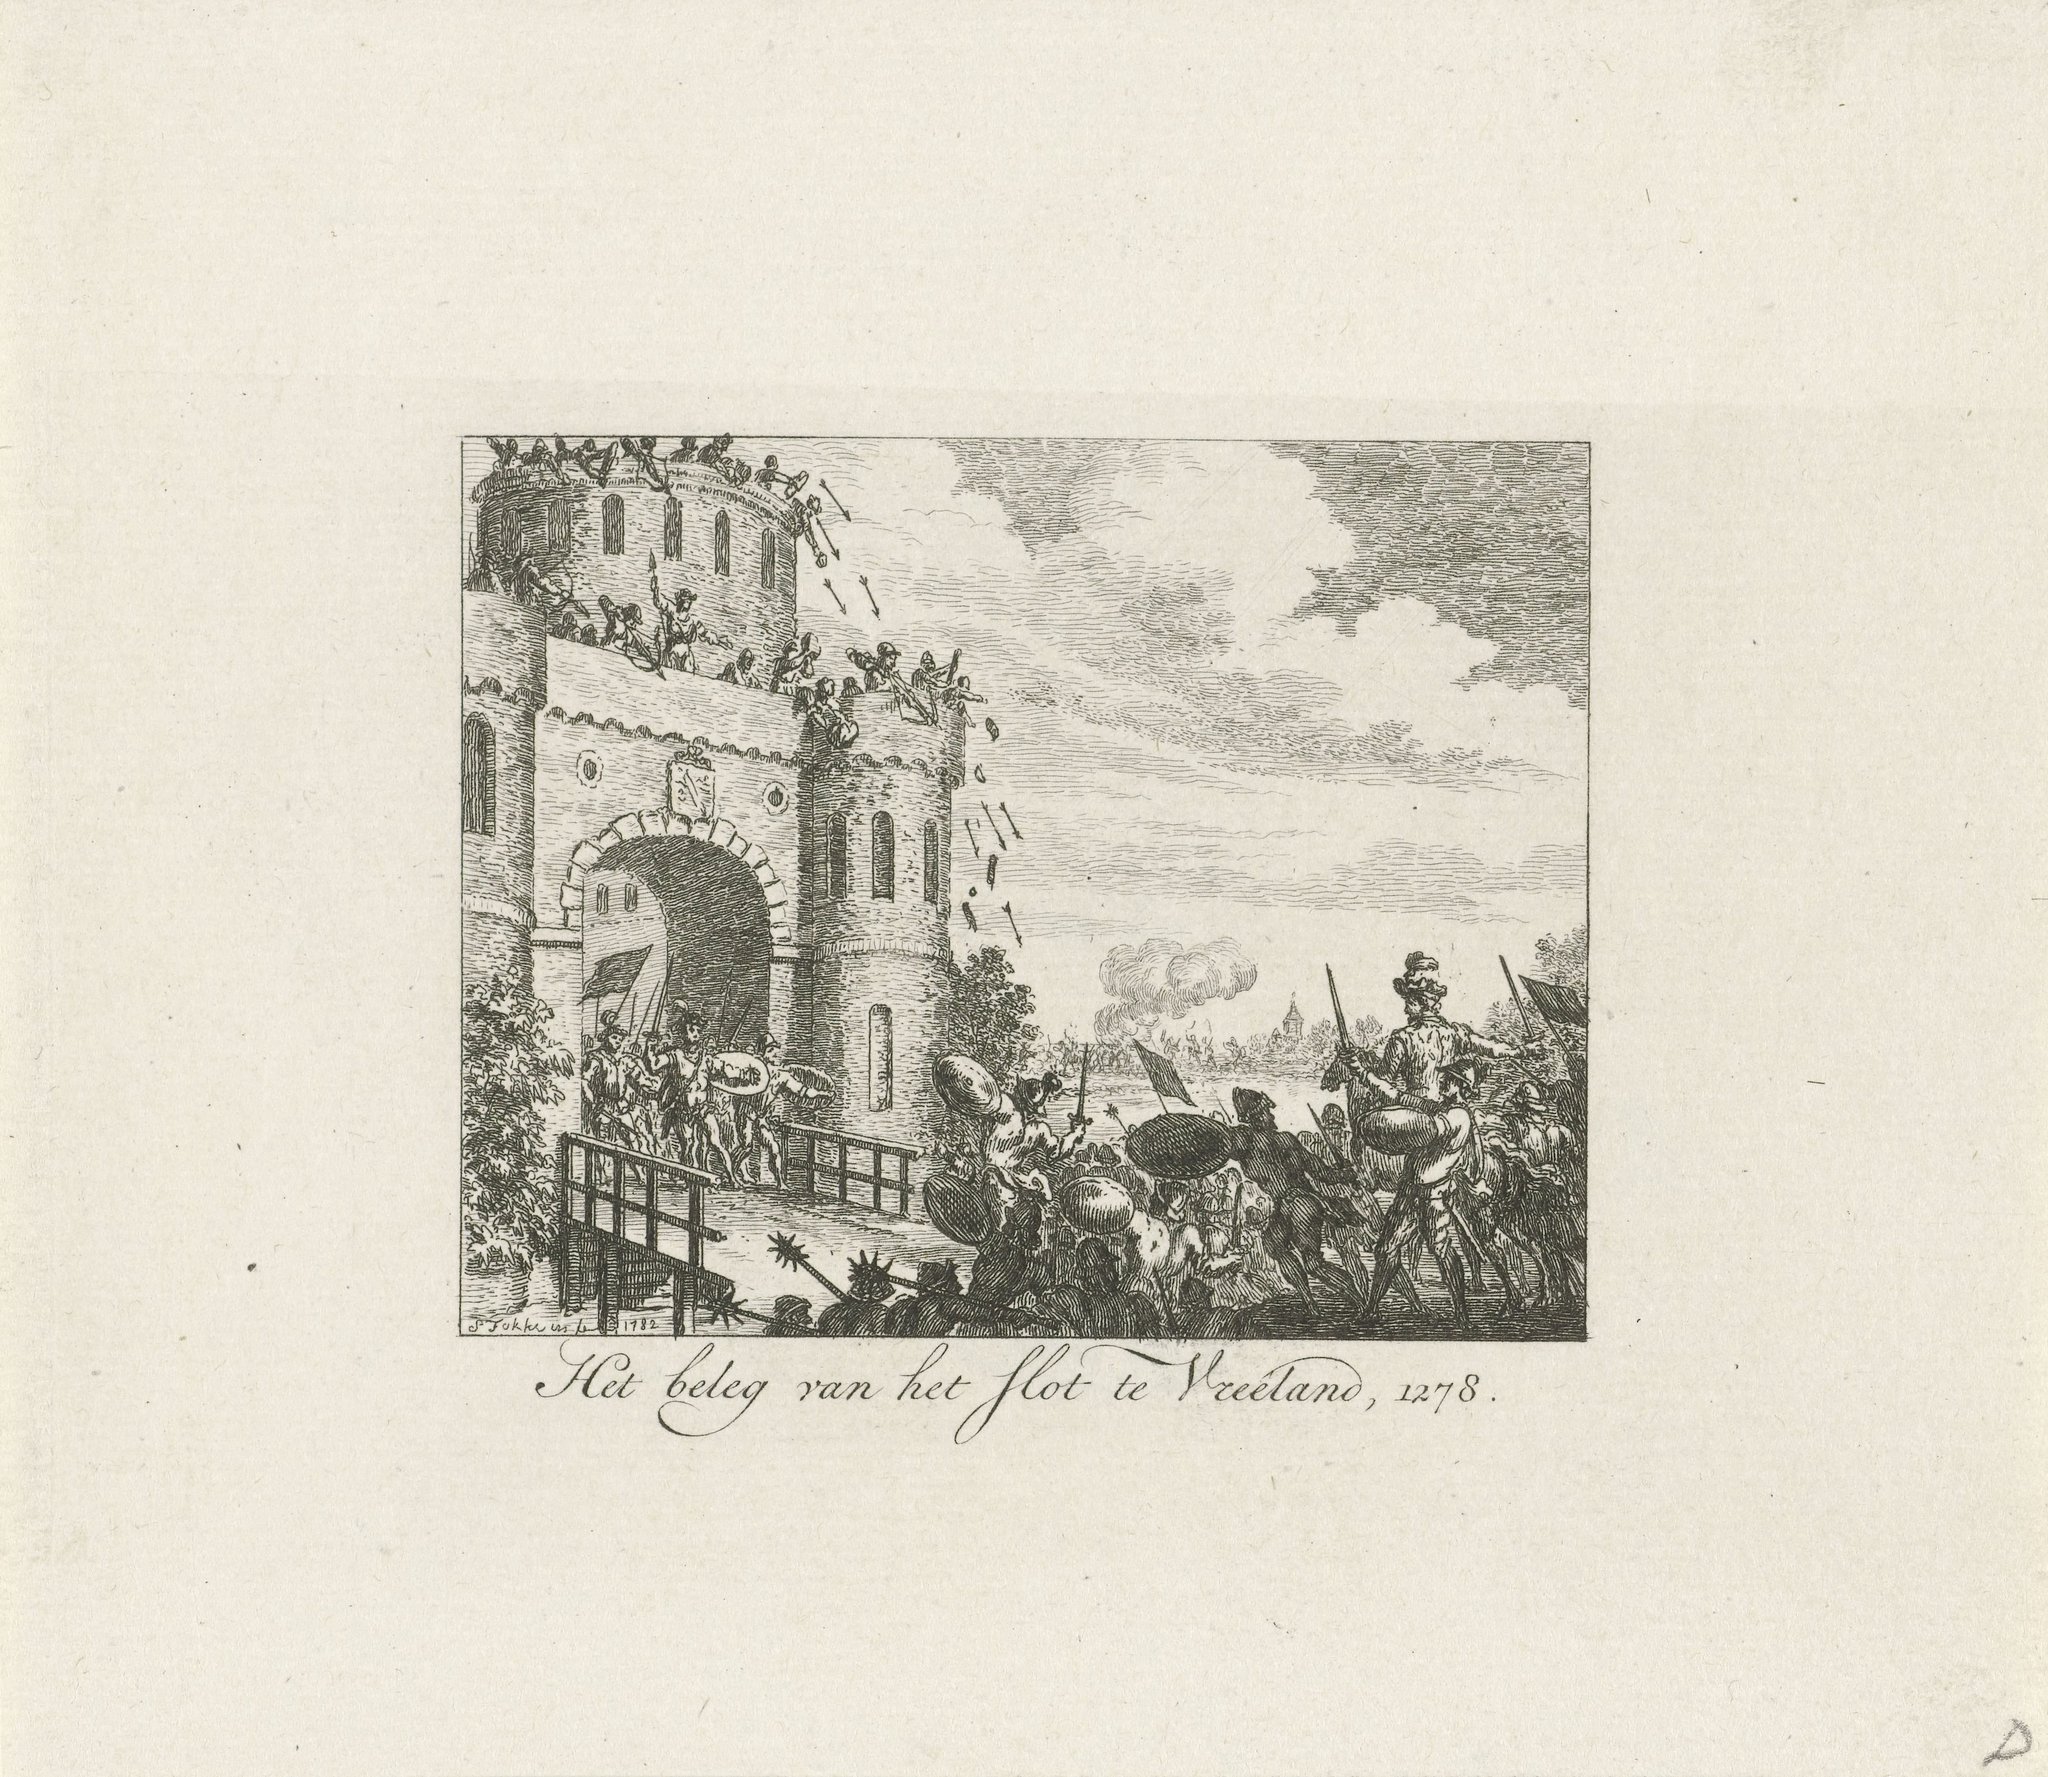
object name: print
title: Het beleg van het Slot te Vreeland, 1278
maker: simon fokke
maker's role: draughtsman, print maker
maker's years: 1712-1784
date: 1782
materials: paper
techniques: etching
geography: amsterdam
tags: floris v (graaf van holland en zeeland), siege, position war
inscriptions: collector's mark: Lugt 2228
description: Beleg van het slot Vreeland of Vredelant door graaf Floris V. Vanaf de torens en vanonder de slotgrachtpoort probeert men de vesting te verdedigen tegen het leger dat probeert binnen te stormen.